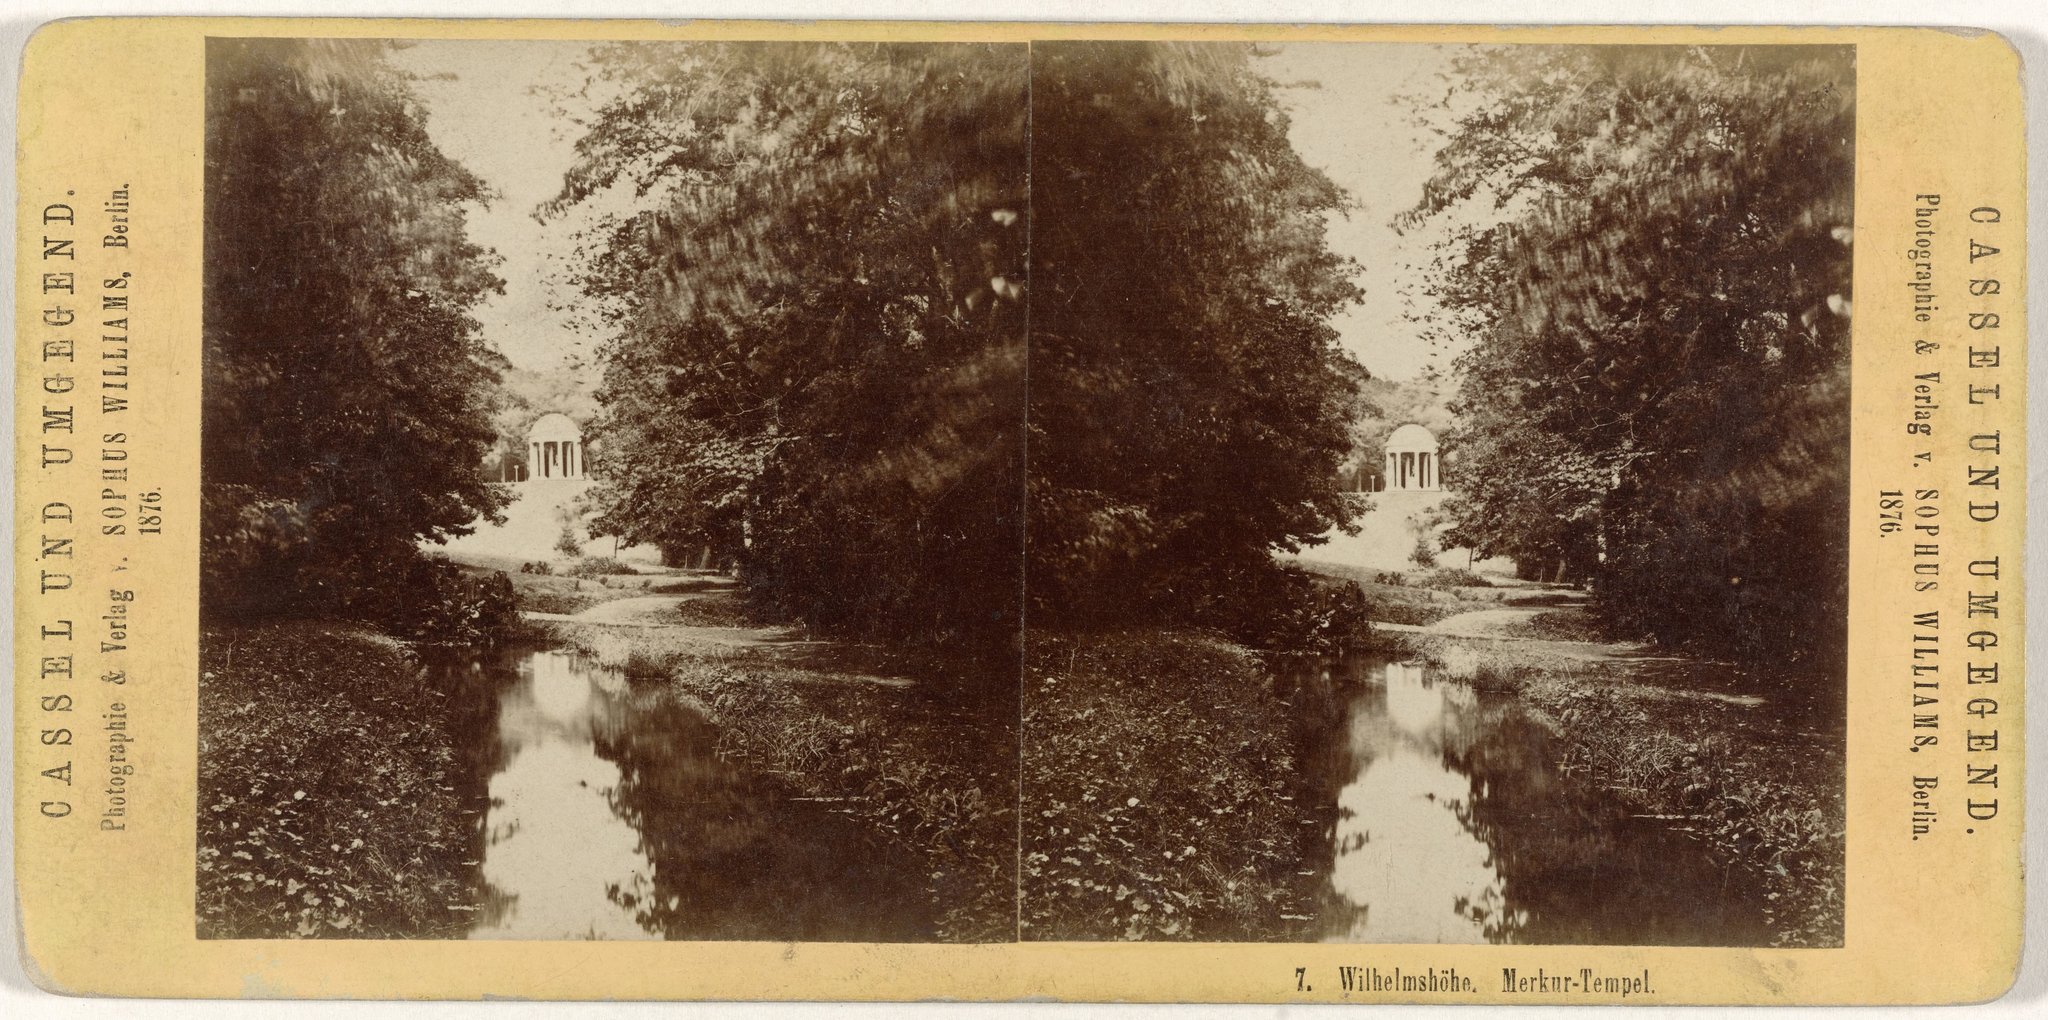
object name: stereograph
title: Wilhelmshöhe. Merkur-Tempel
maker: sophus williams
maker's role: publisher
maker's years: 1835-1900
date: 1876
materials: cardboard, paper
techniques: albumen print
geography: berlin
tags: summer-house, arbour, garden-house (dutch: 'theekoepel')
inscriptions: number: ‘7.’